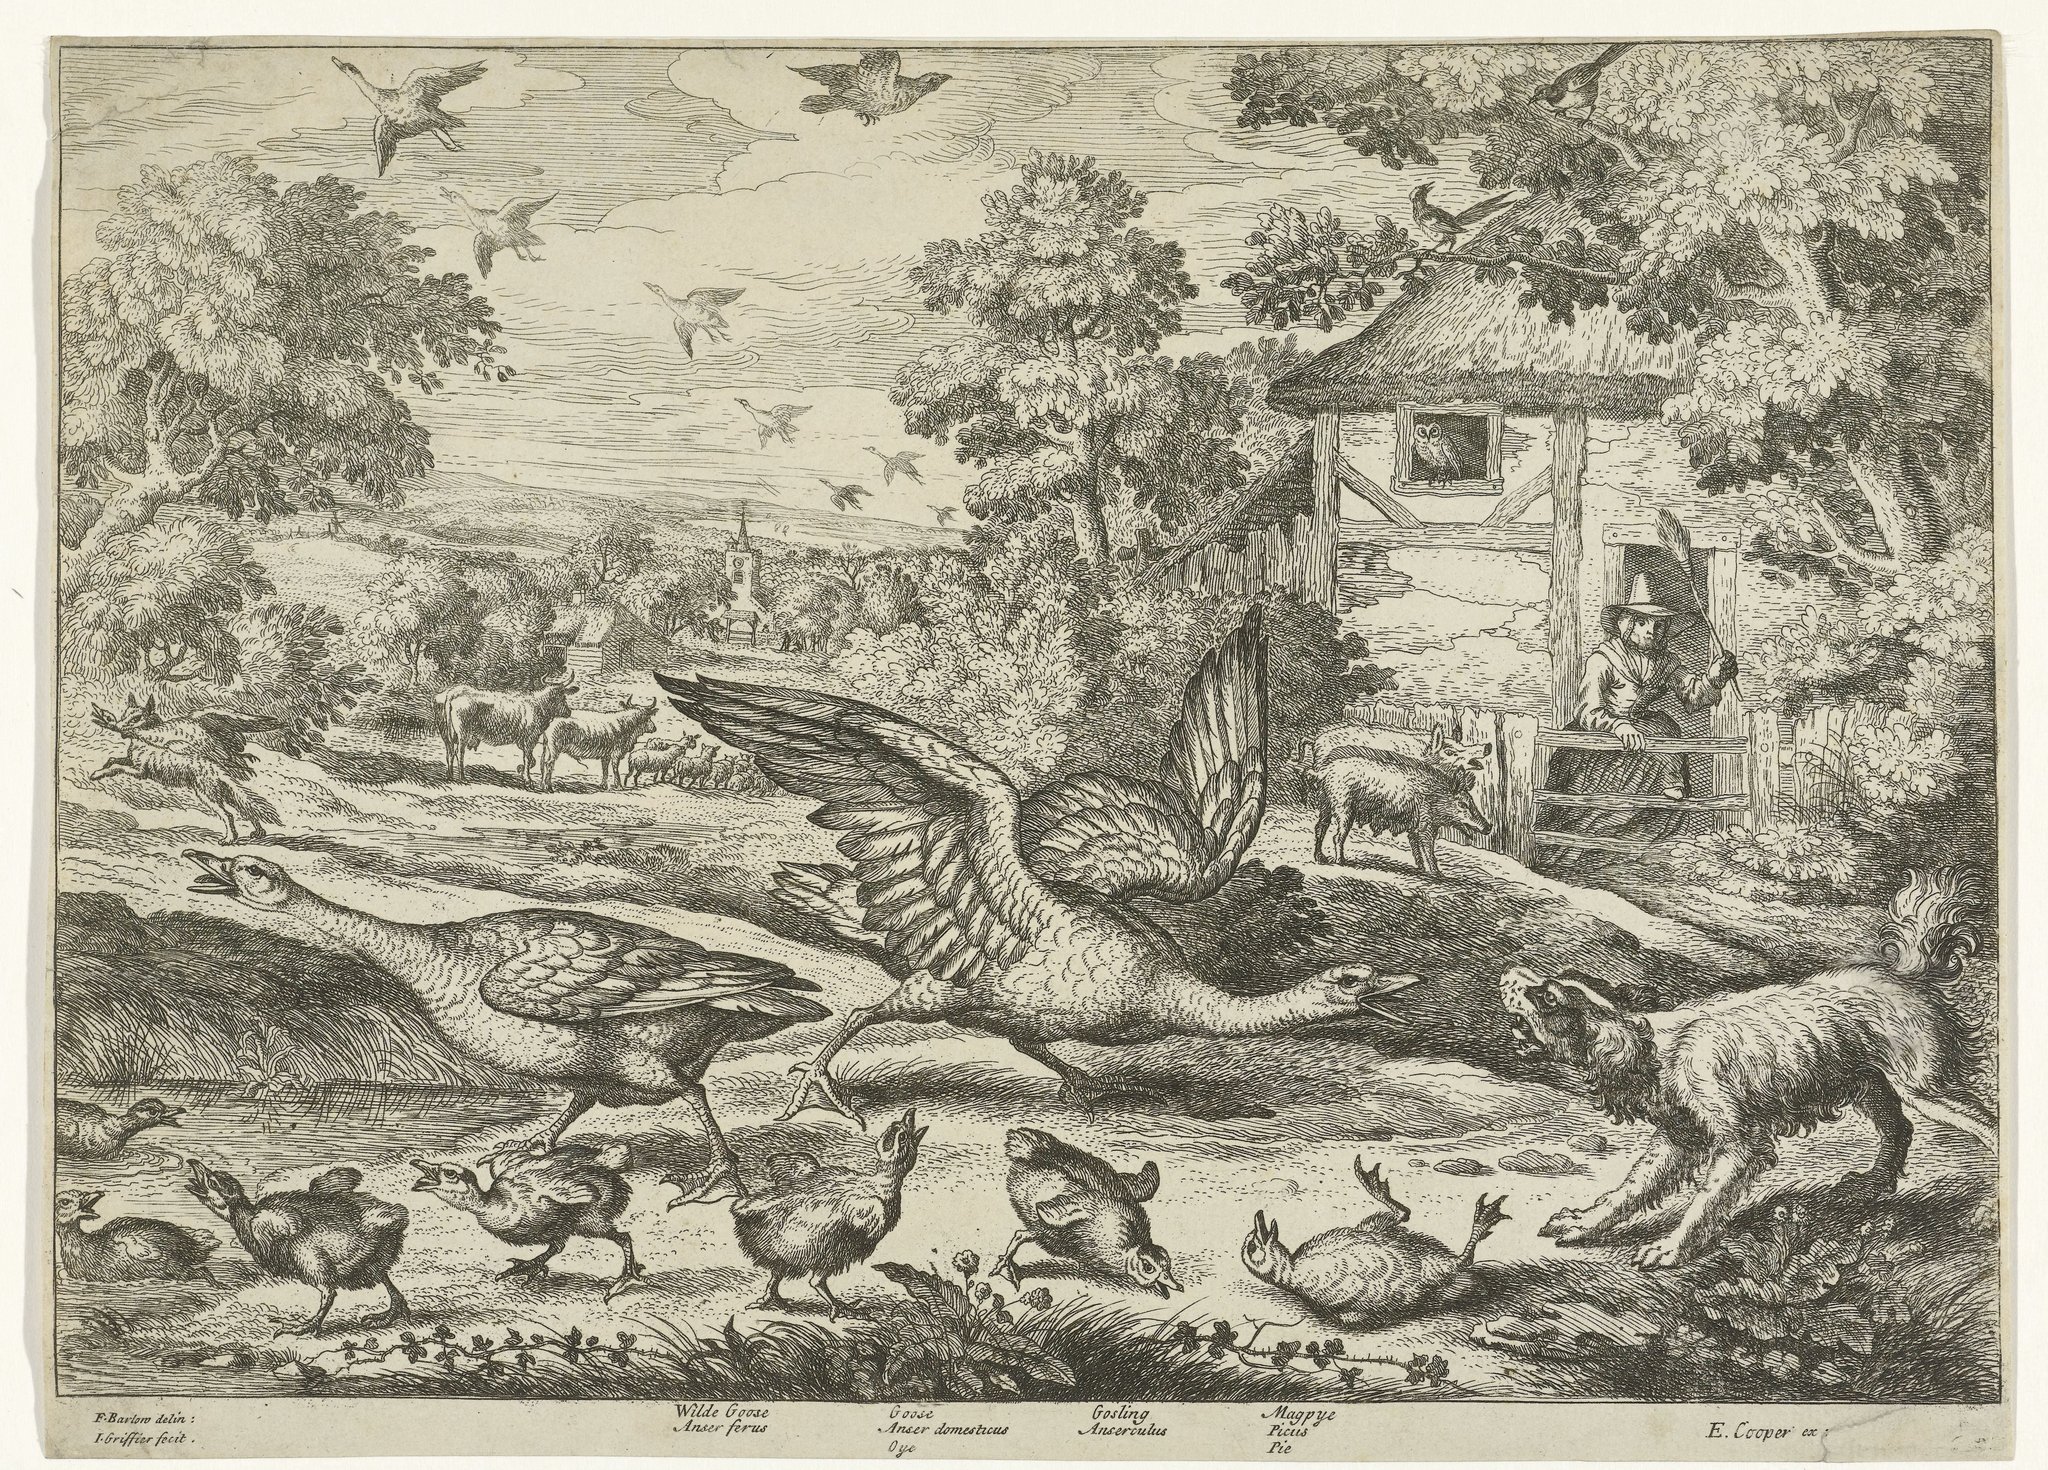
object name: print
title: Landschap met twee ganzen die hun jongen verdedigen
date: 1655-1718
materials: paper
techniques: engraving, etching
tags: dog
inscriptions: collector's mark: Lugt 2228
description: Landschap met op de voorgrond twee ganzen die hun jongen verdedigen tegen een blaffende hond. Rechts staat een vrouw achter een hek met een bezem in haar hand. Op de achtergrond is een kerktoren te zien. In de marge staan de namen van de voorgestelde dieren in het Engels, Latijn en Frans.